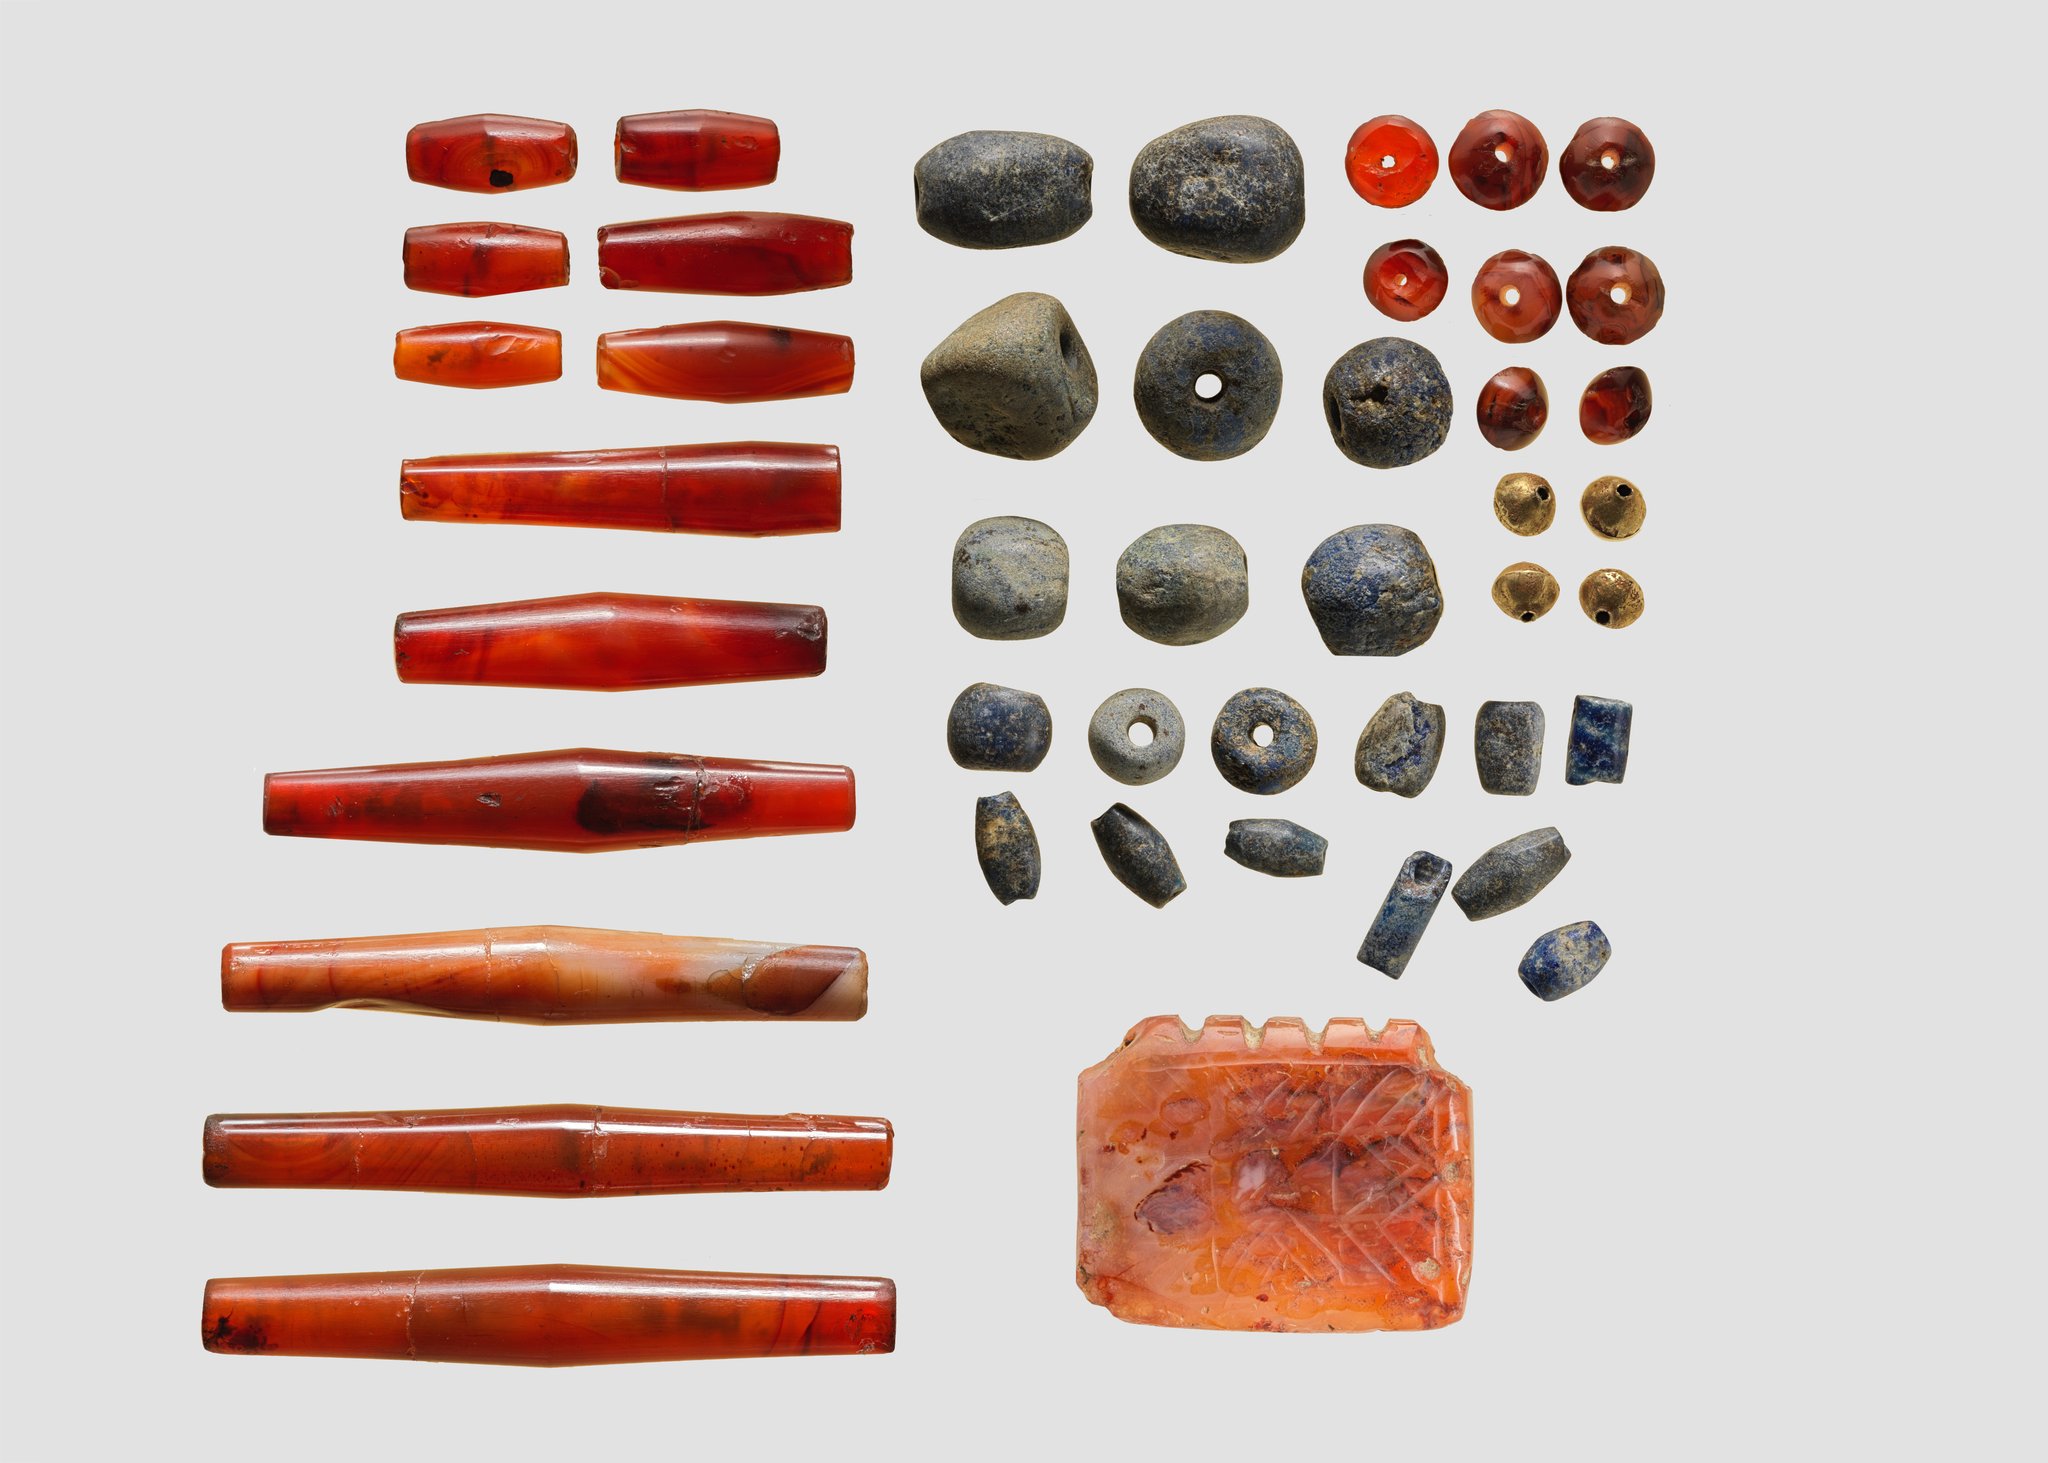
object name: bead and pendant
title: Pendant and beads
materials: gemstone, gold, lapis lazuli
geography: syria